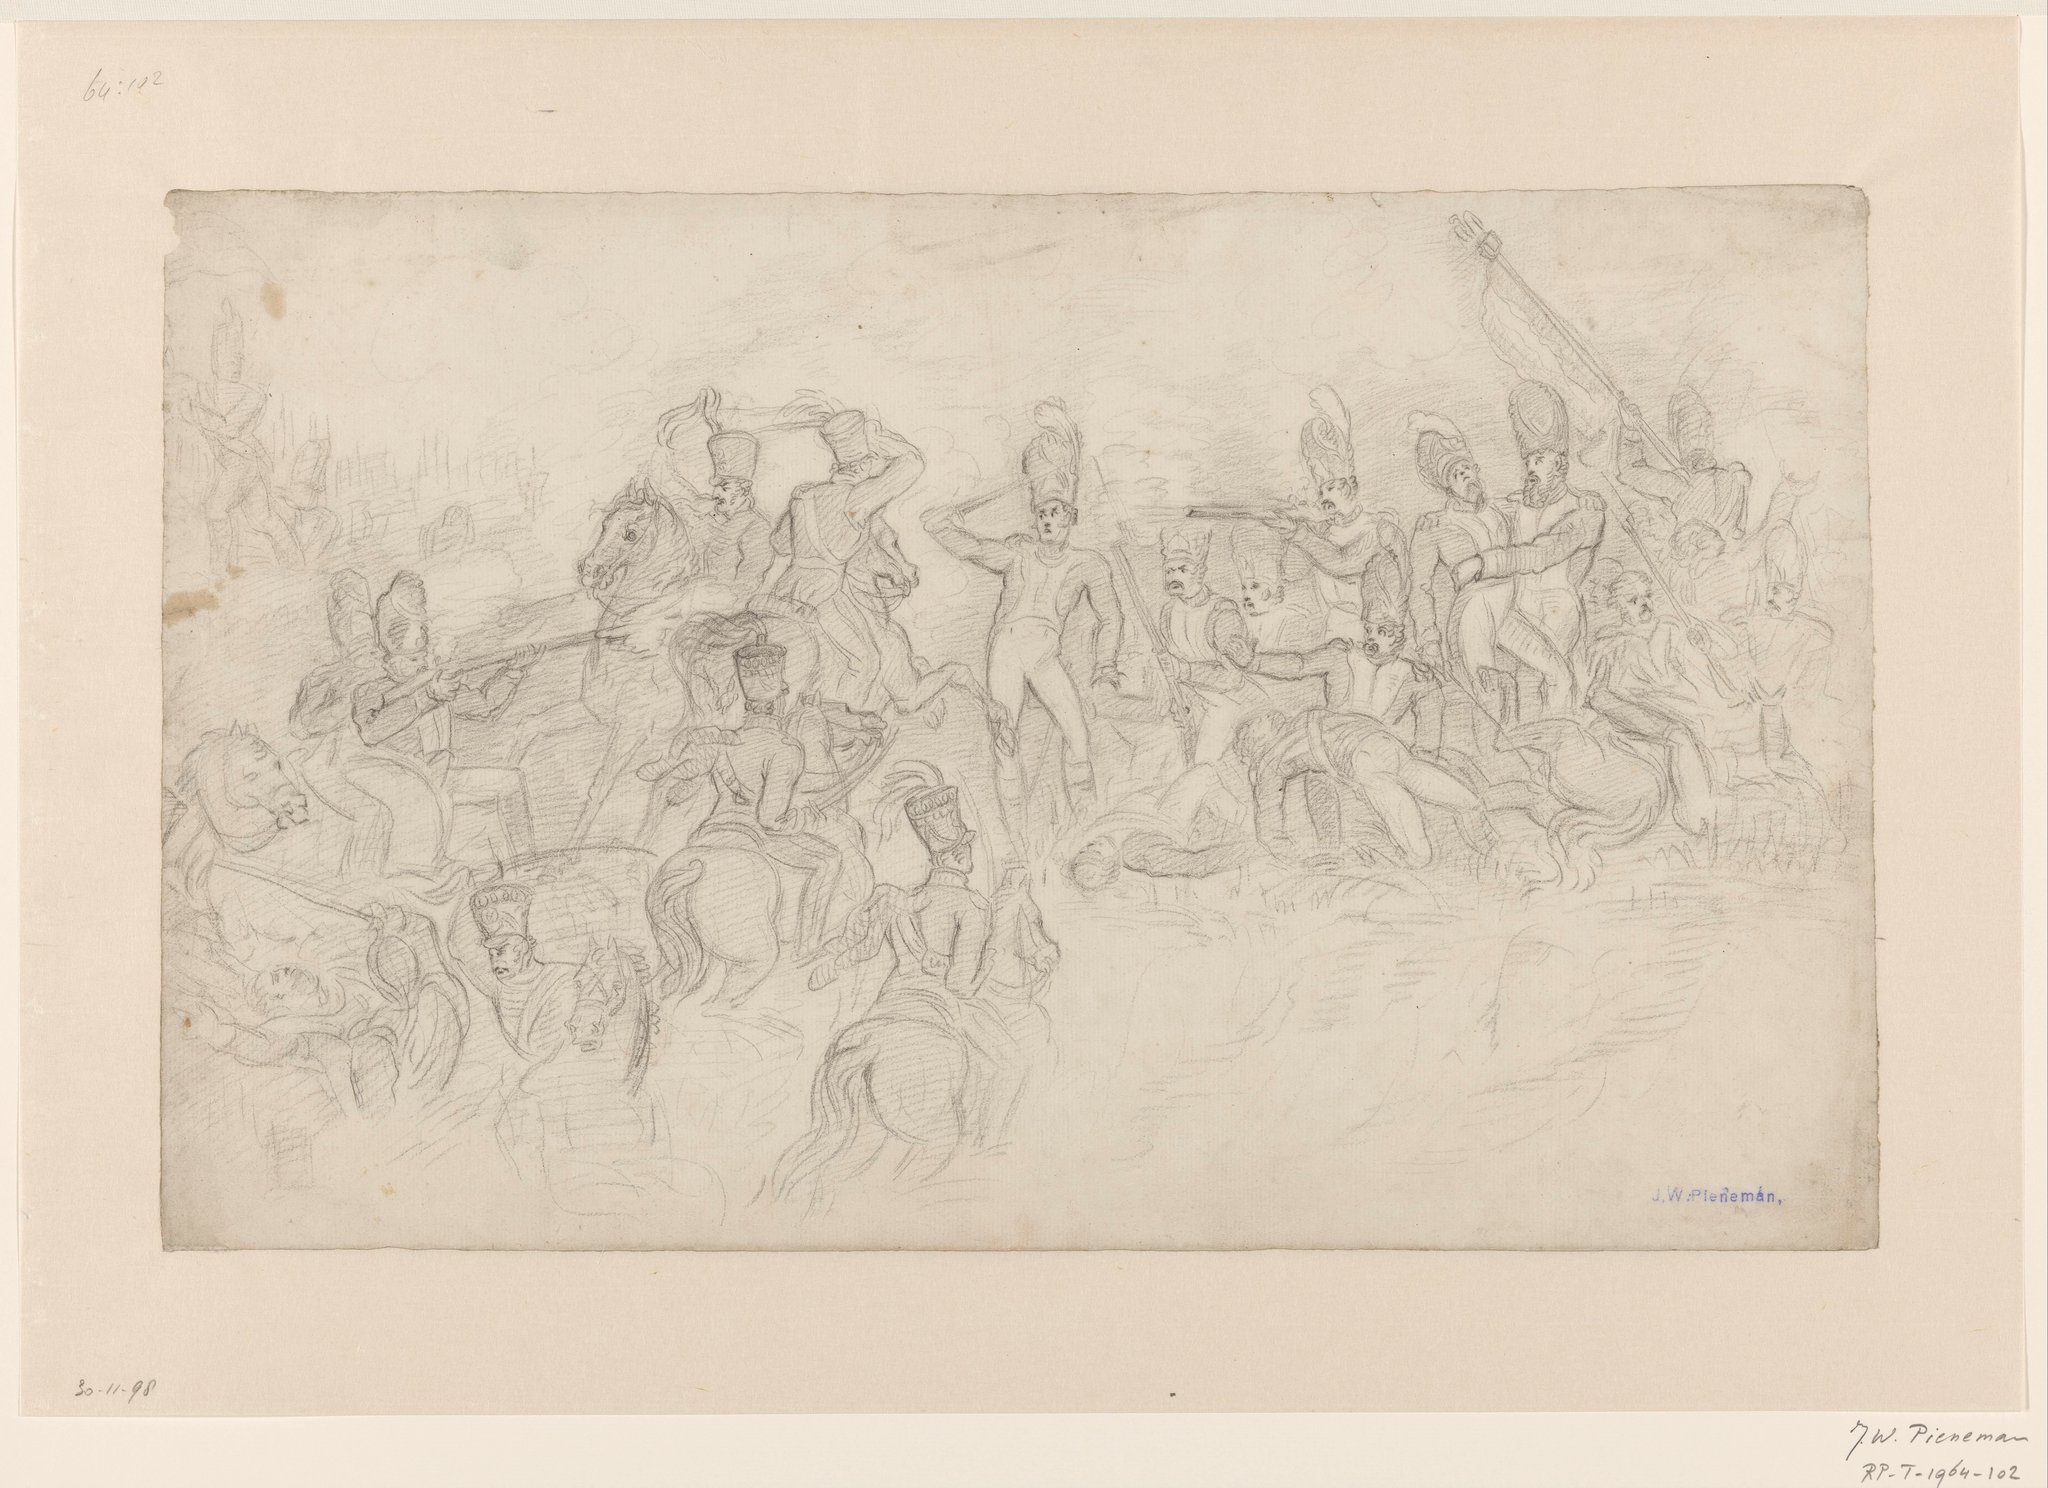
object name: drawing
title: Detail uit het schilderij De Slag bij Waterloo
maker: jan willem pieneman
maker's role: draughtsman, painter, print maker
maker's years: 1779-1853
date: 1789-1853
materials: chalk, paper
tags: battle (+ land forces), historical events and situations